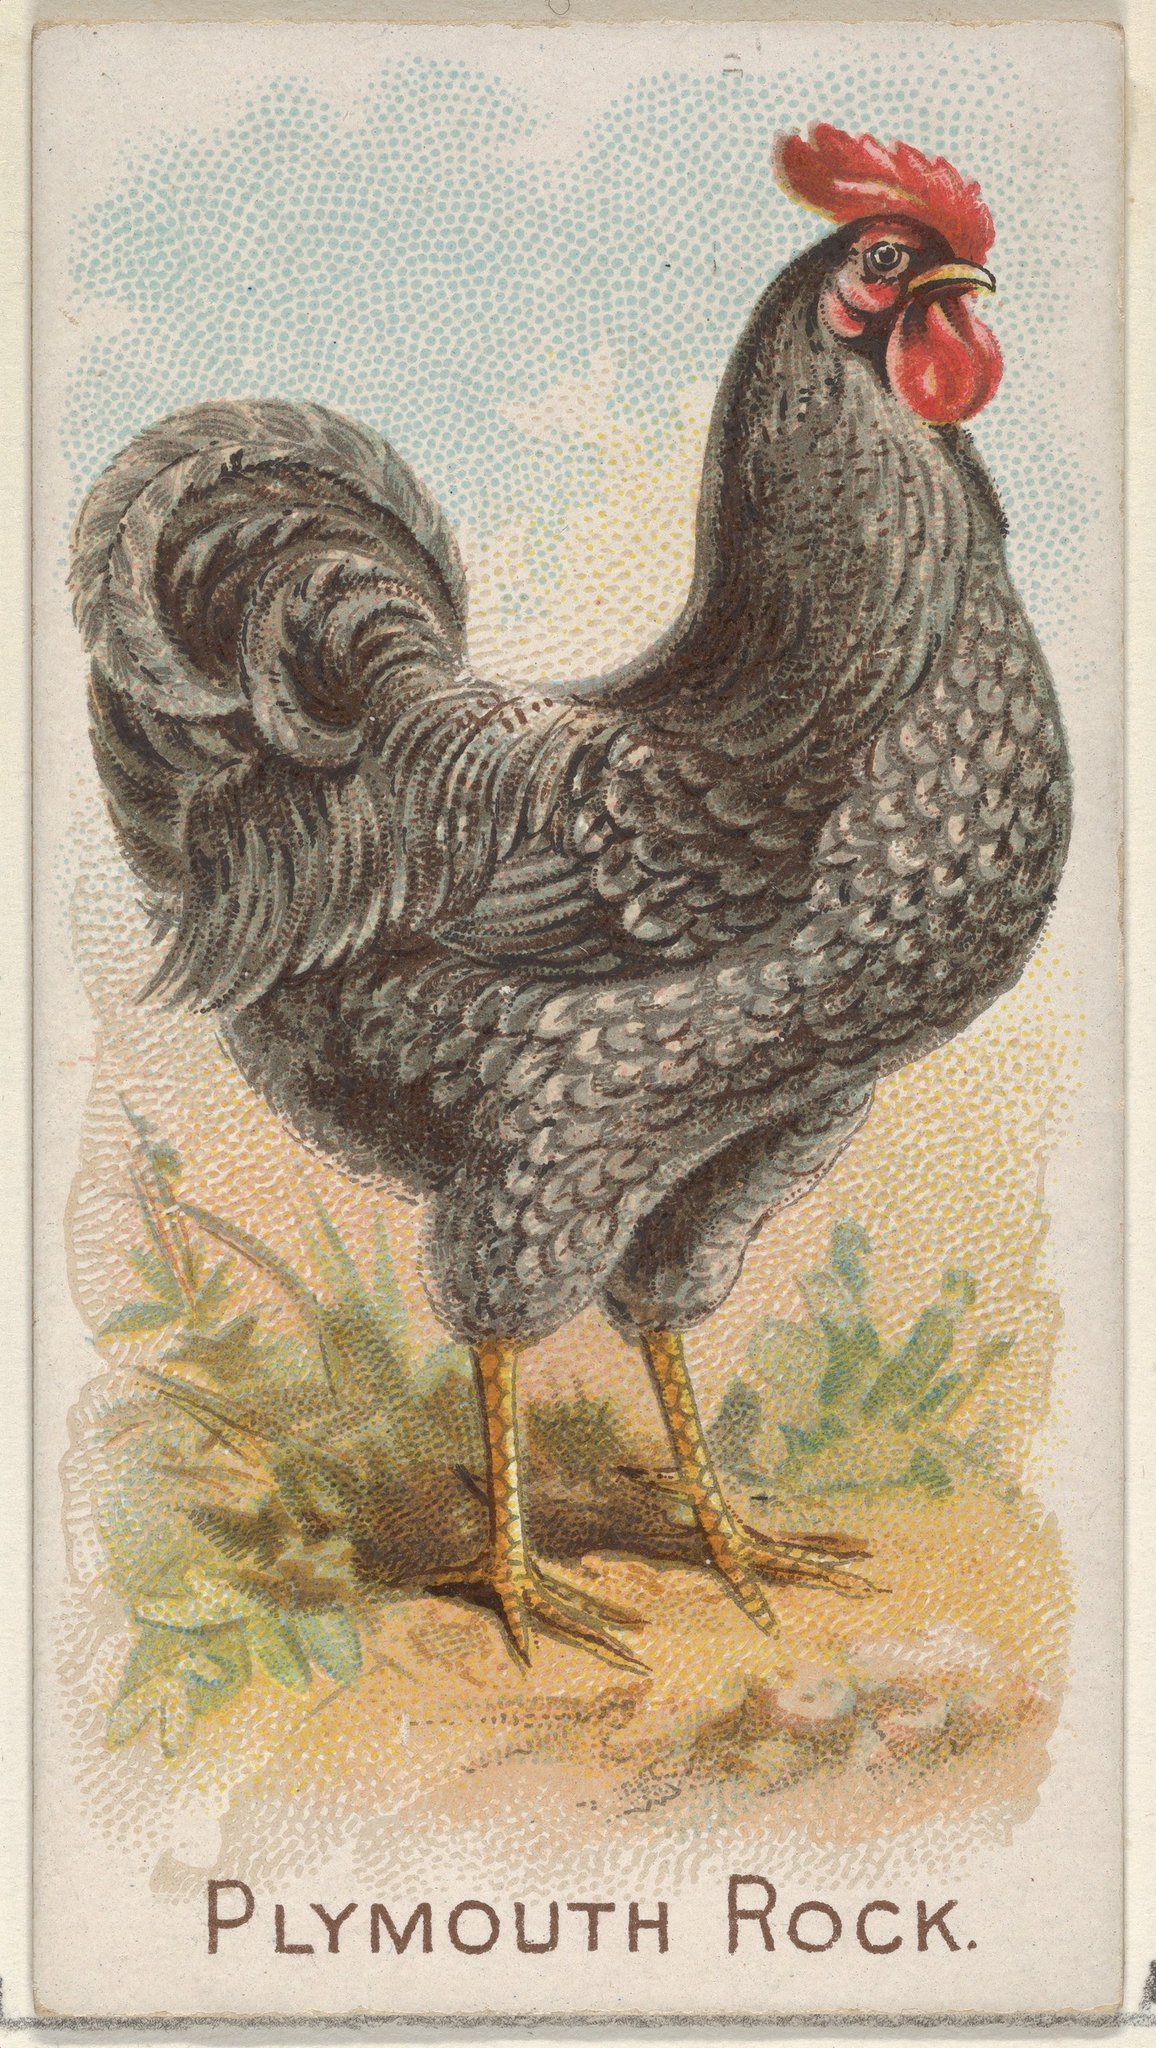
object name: print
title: Plymouth Rock, from the Prize and Game Chickens series (N20) for Allen & Ginter Cigarettes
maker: allen & ginter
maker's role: publisher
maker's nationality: american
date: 1891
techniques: color lithograph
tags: chickens